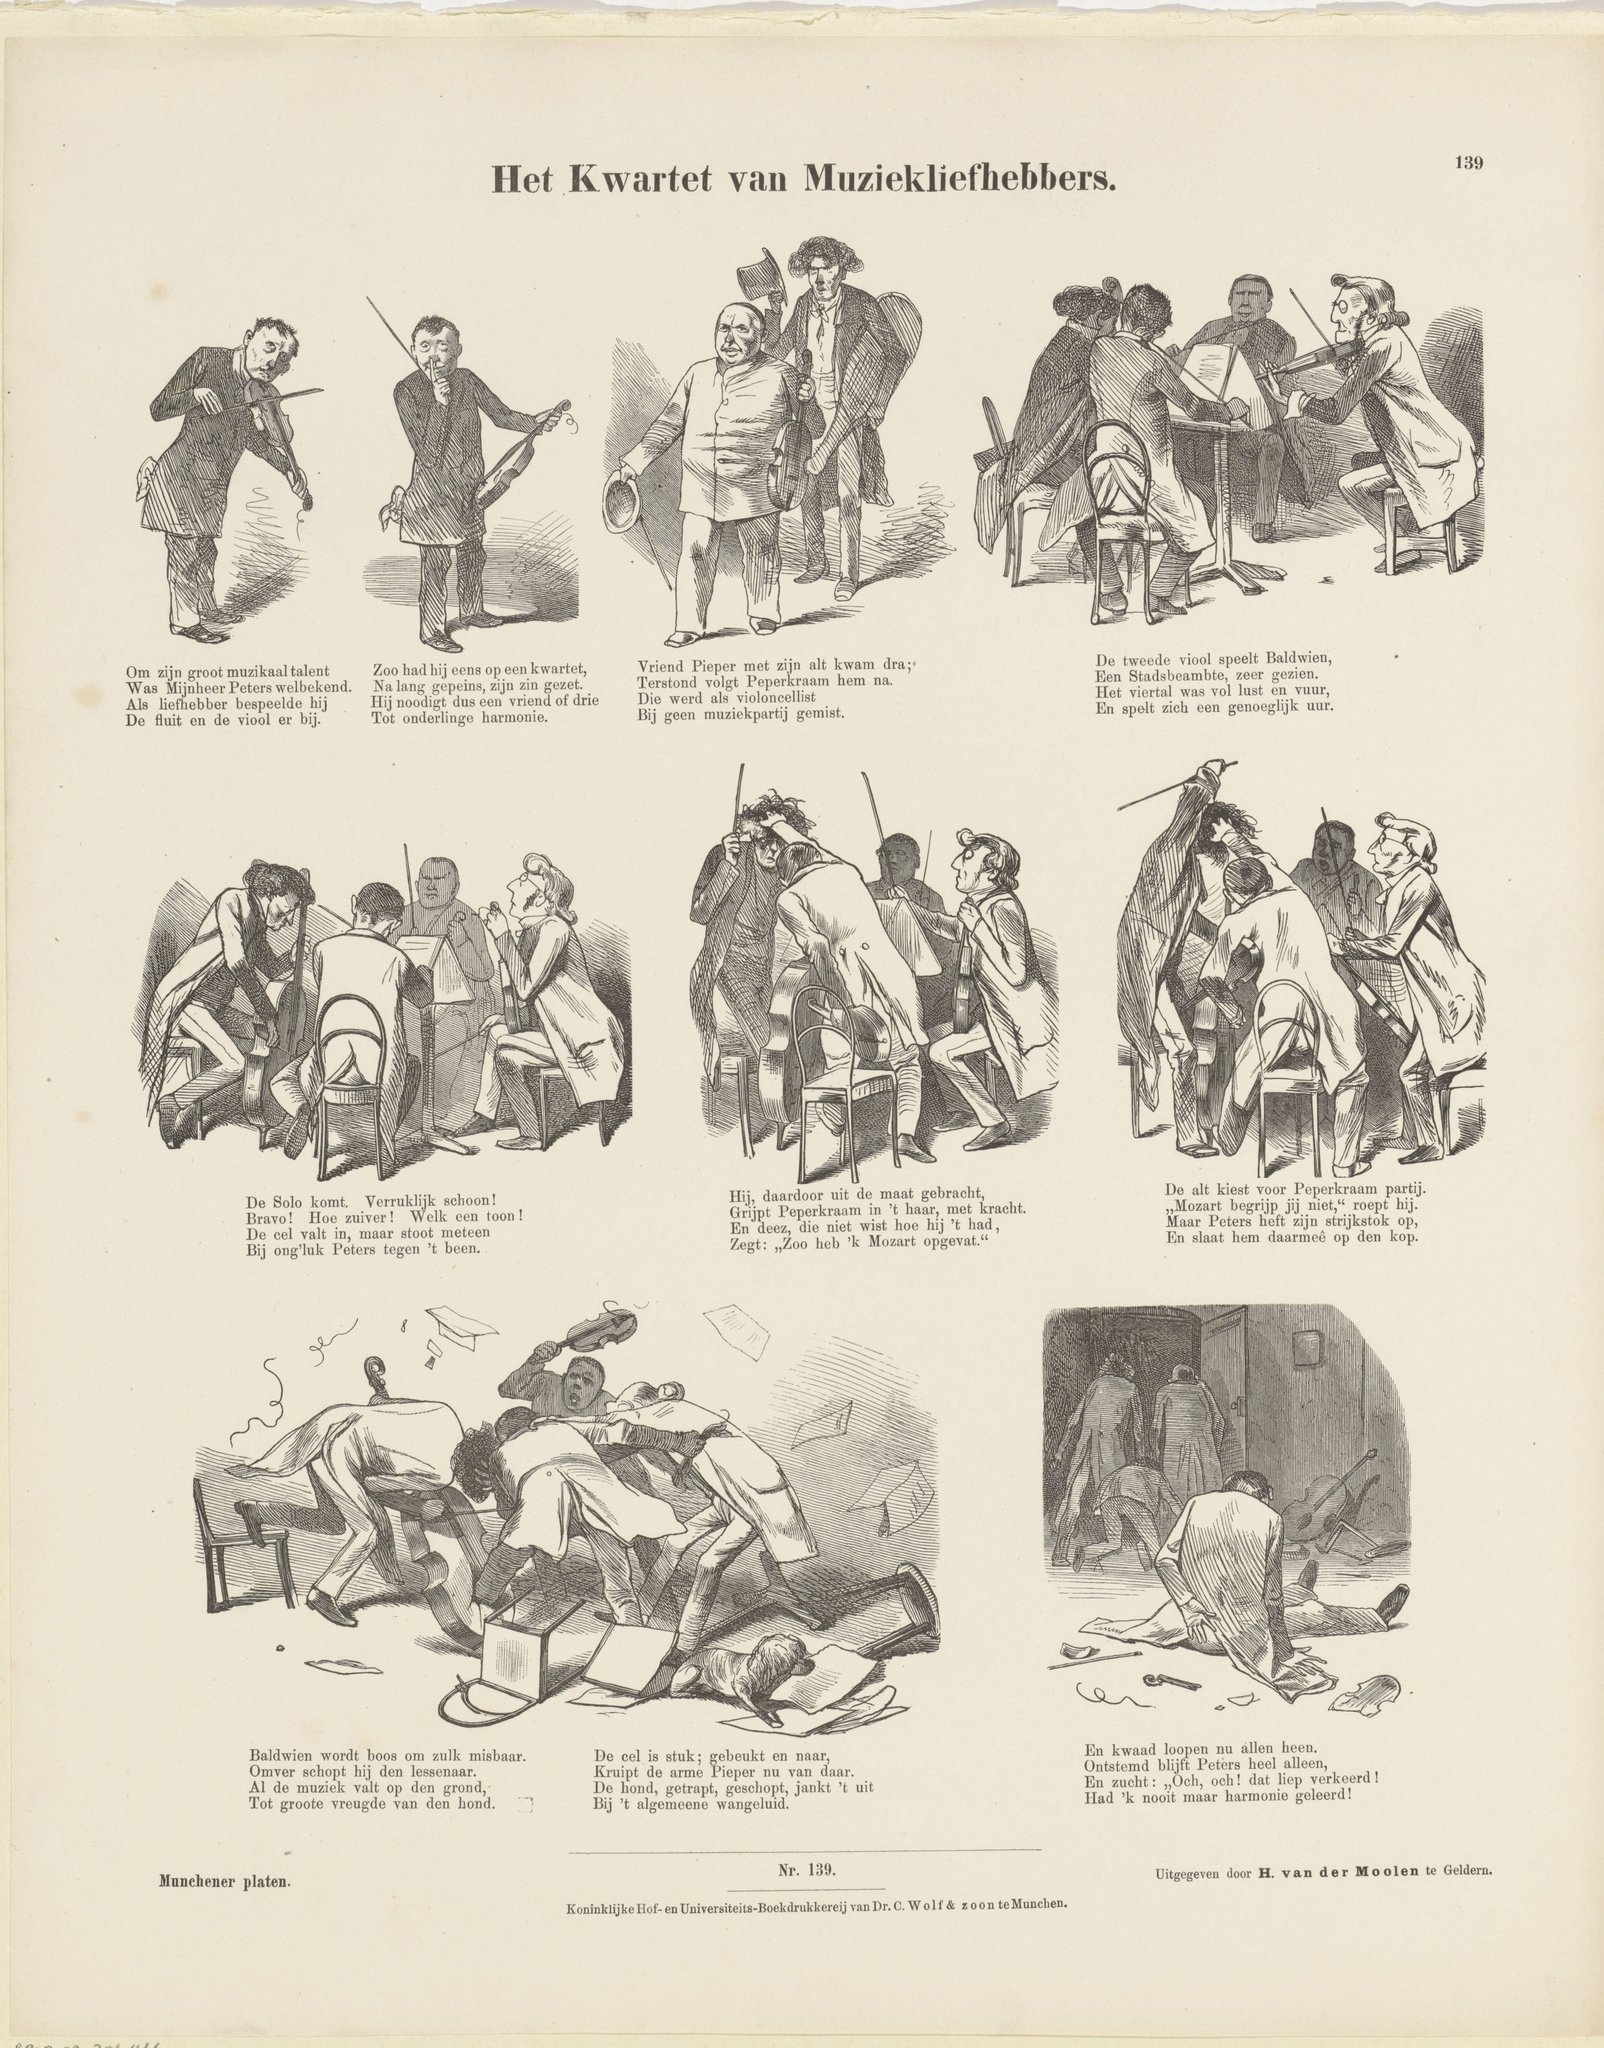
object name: popular print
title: Het kwartet van muziekliefhebbers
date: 1843-1920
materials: paper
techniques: letterpress printing, engraving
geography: germany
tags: small group of musicians, chamber orchestra, jazz band, fighting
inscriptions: collector's mark: Lugt 2760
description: Blad met 9 voorstellingen over een strijkkwartet dat ruzie krijgt tijdens het spelen. Onder elke afbeelding een vers. Genummerd midden onder: Nro. 139. Genummerd rechtsboven: 139.